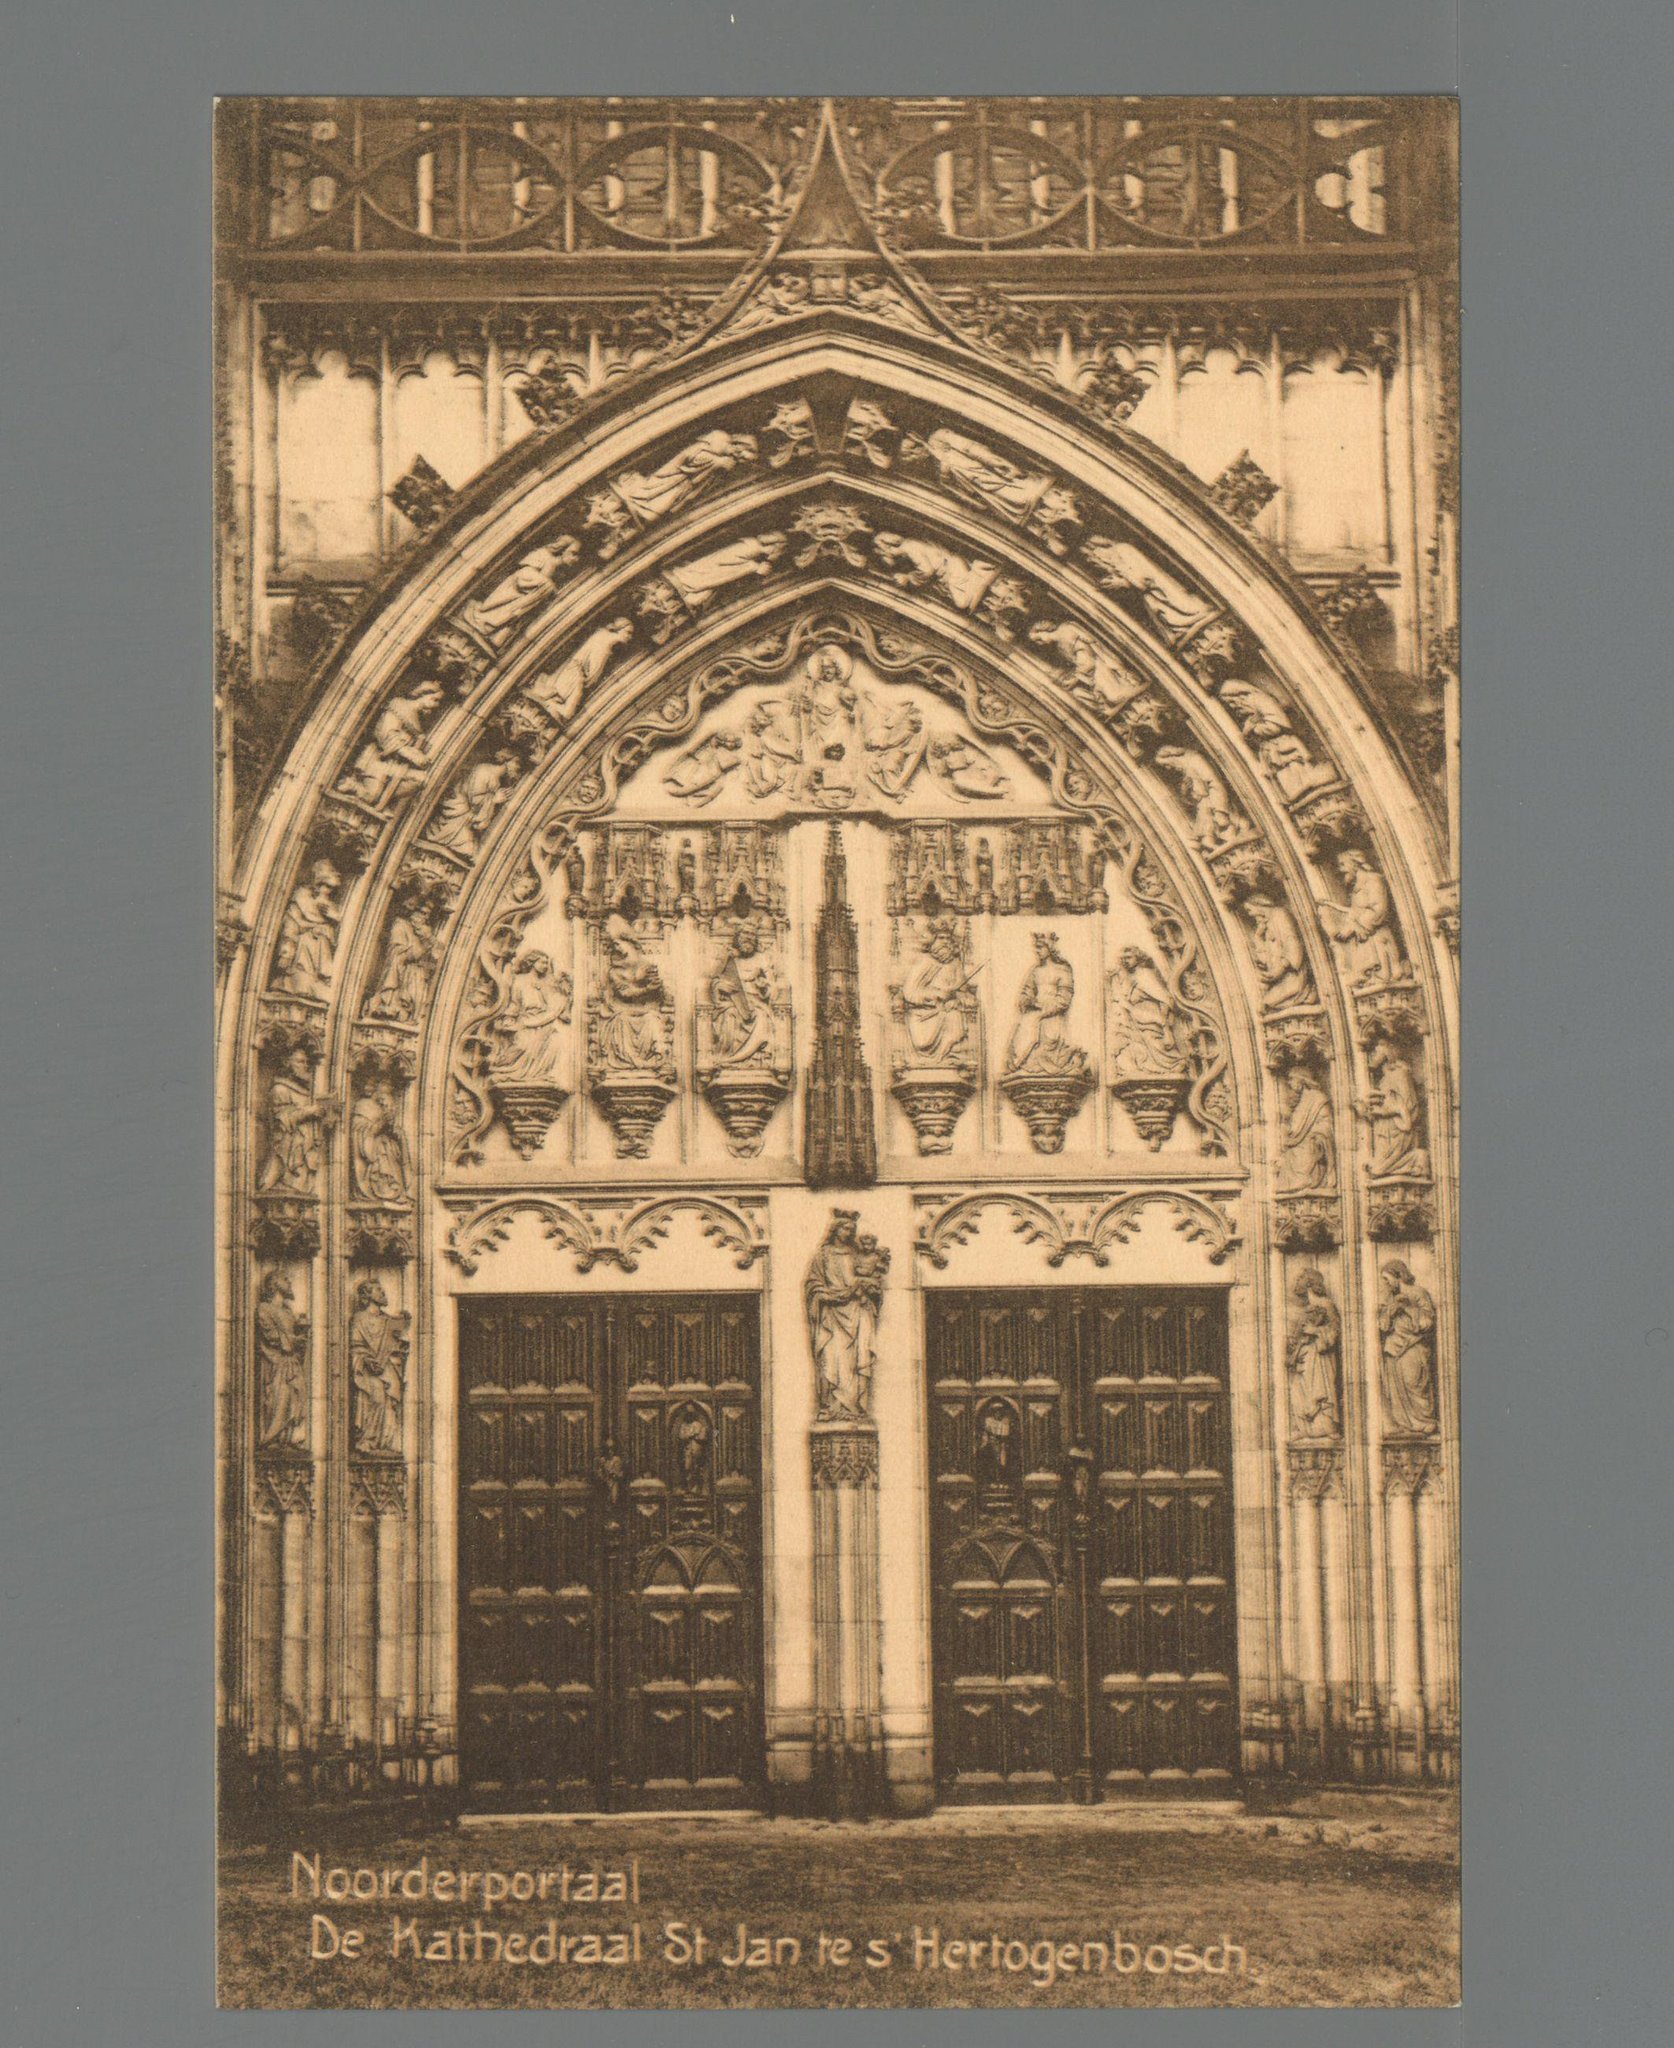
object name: photomechanical print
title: De Kathedraal St Jan te s' Hertogenbosch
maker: Anonymous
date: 1905-1930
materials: cardboard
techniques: photograph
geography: den bosch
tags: parts of church exterior and annexes: portal